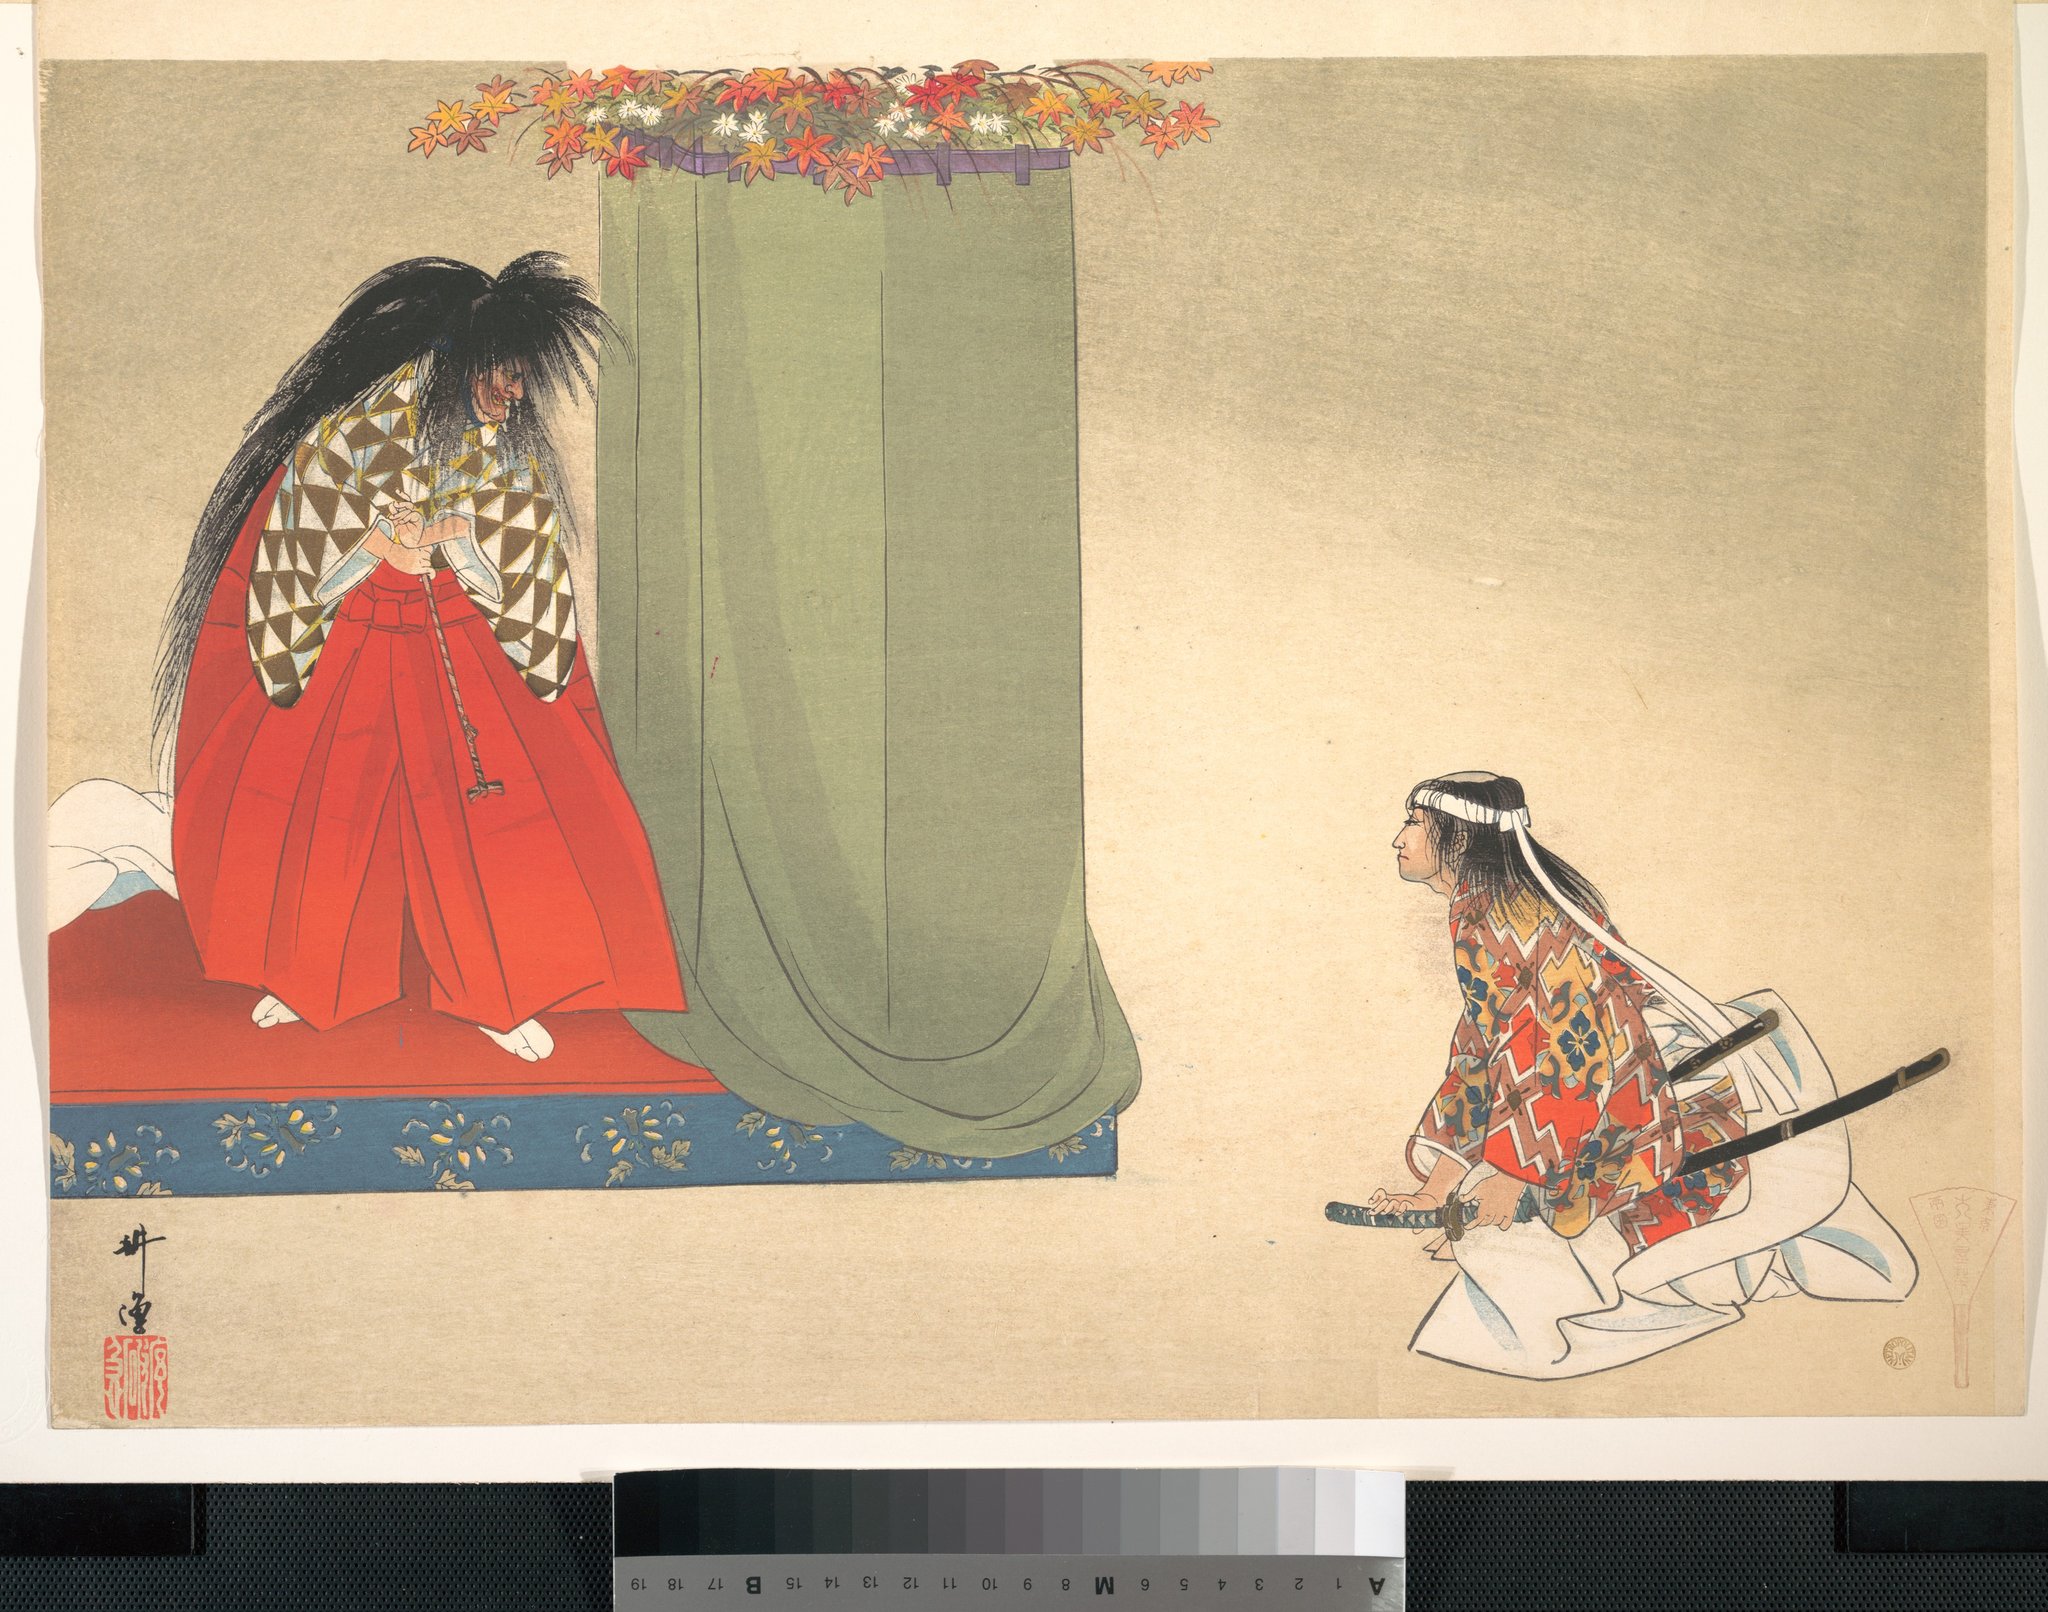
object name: print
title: Illustration of Noh Dance Scene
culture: japanese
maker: okumura masanobu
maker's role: artist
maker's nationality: japanese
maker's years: 1686-1764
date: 1910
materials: ink, paper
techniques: woodblock print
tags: human figures,dance,swords,flowers